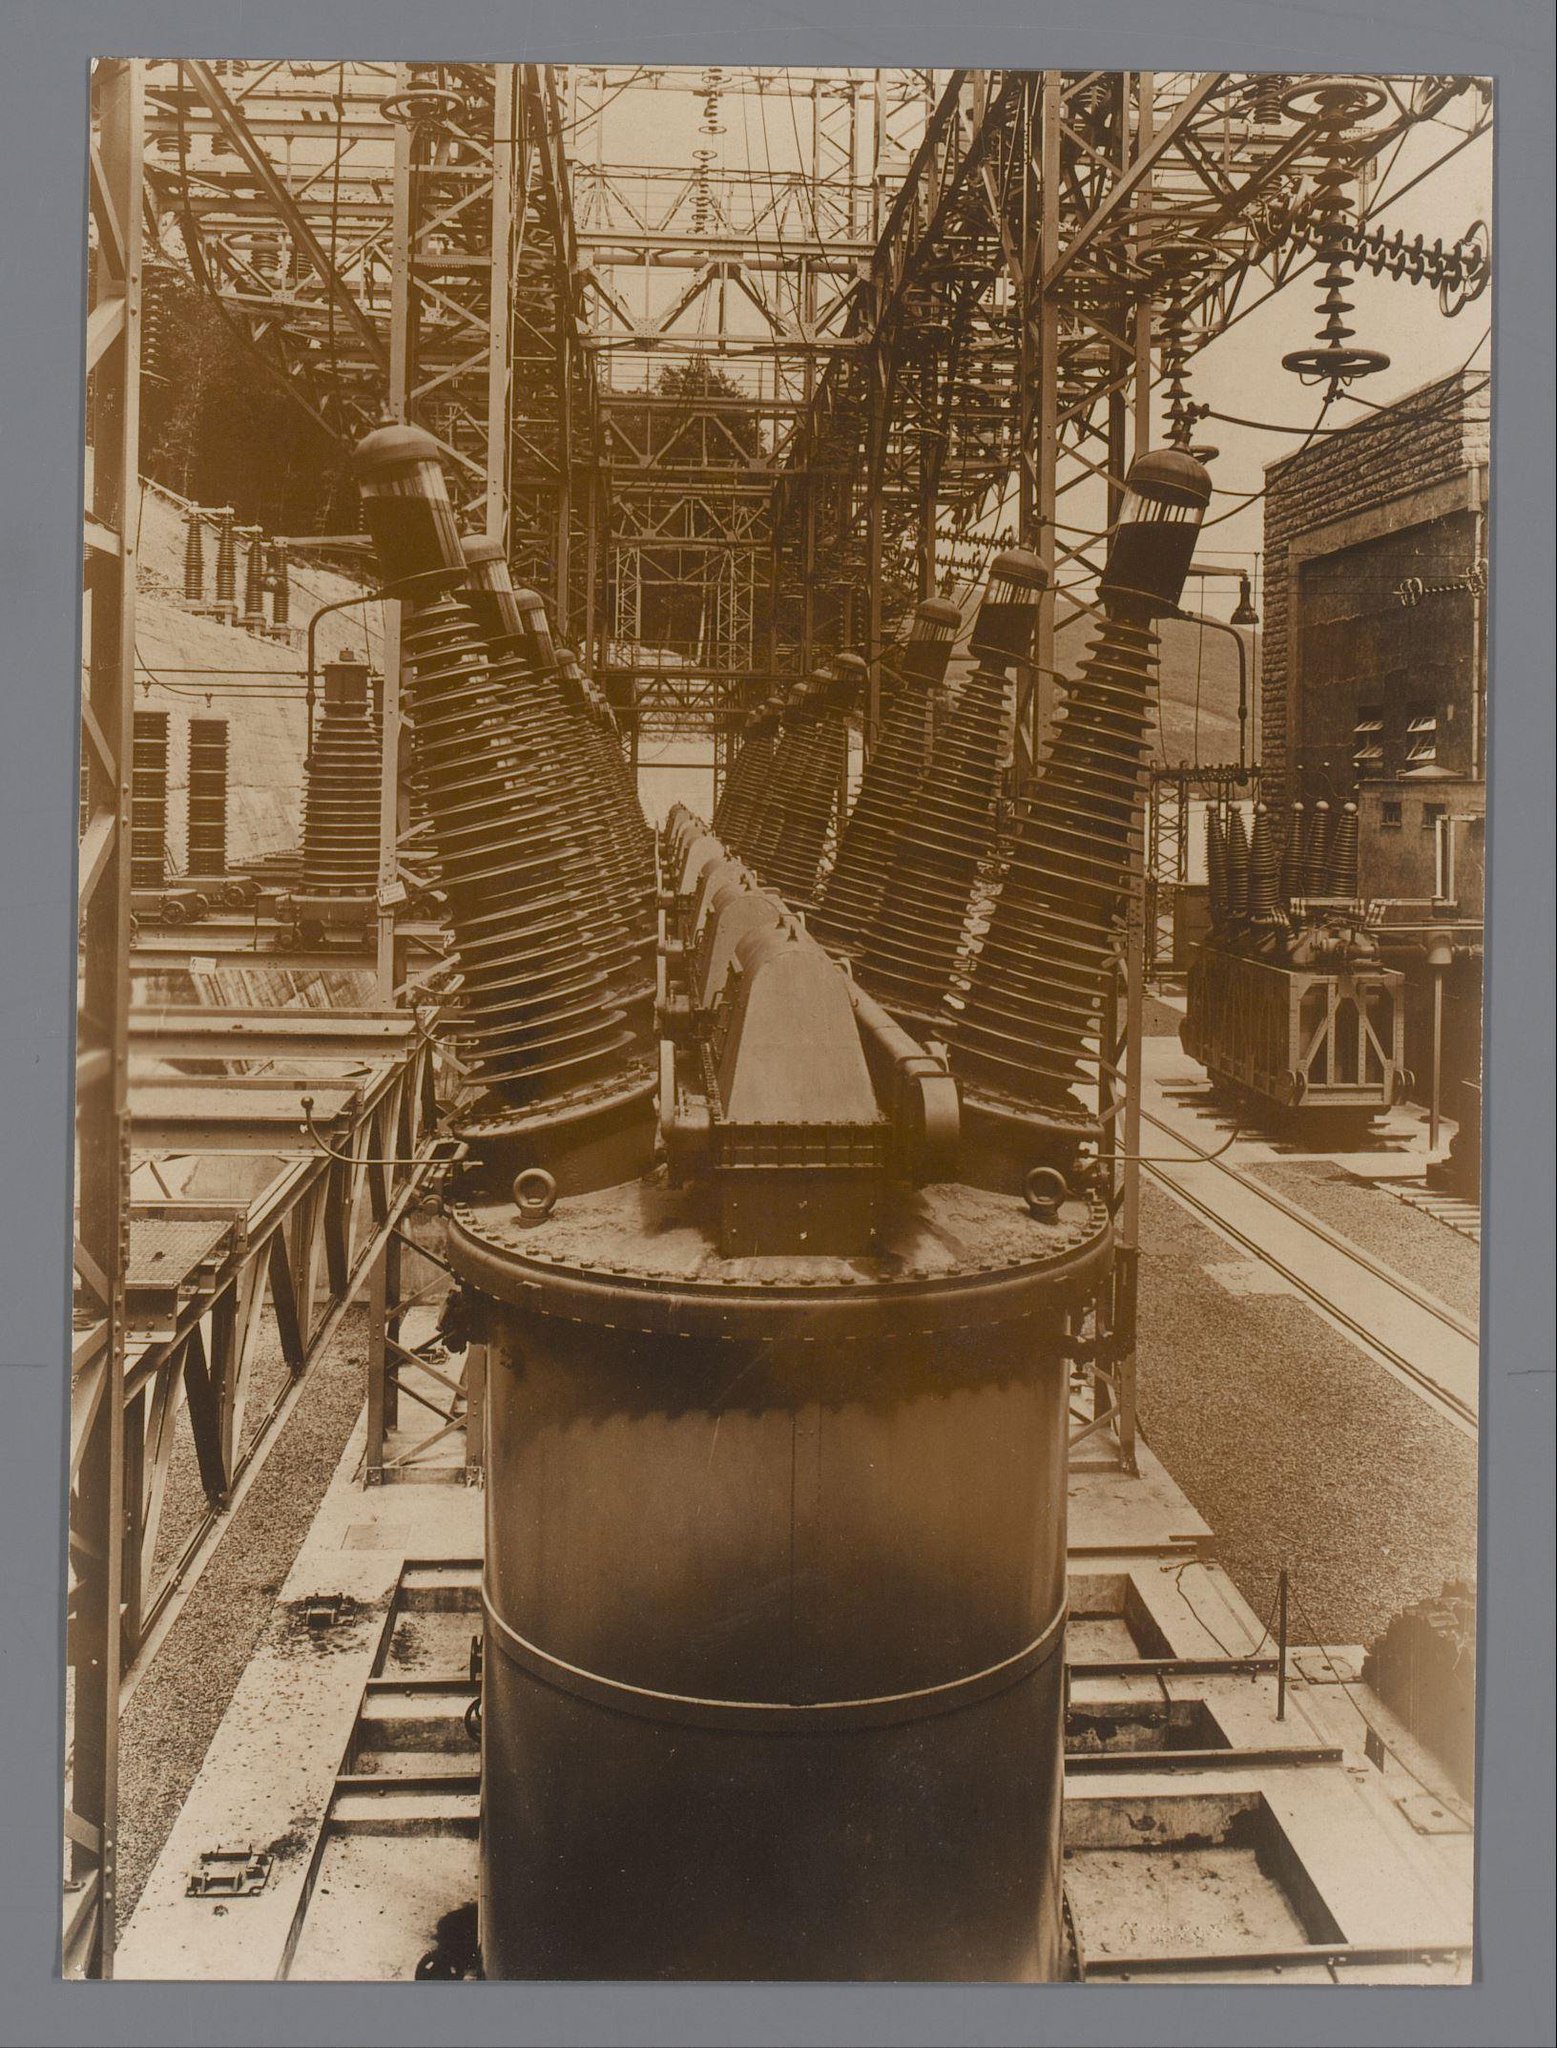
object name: photograph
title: Waterkrachtcentrale met stuwdam (detail olie-machine), Duitsland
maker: a. gross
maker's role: fotograaf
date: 1910-1930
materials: paper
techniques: gelatin silver print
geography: berlin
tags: germany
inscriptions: stamp: ‘A.GROSS//Jllustrations-Verlag[sic]//Berlin SW68//Zimmerstr. 48b’, label: ‘Das grösste Speicherkraftwerk//der Welt.//2399//Blick auf die 220,000 Volt Oel-//schalter im Kraftwerk . //Text ohne Gewähr’